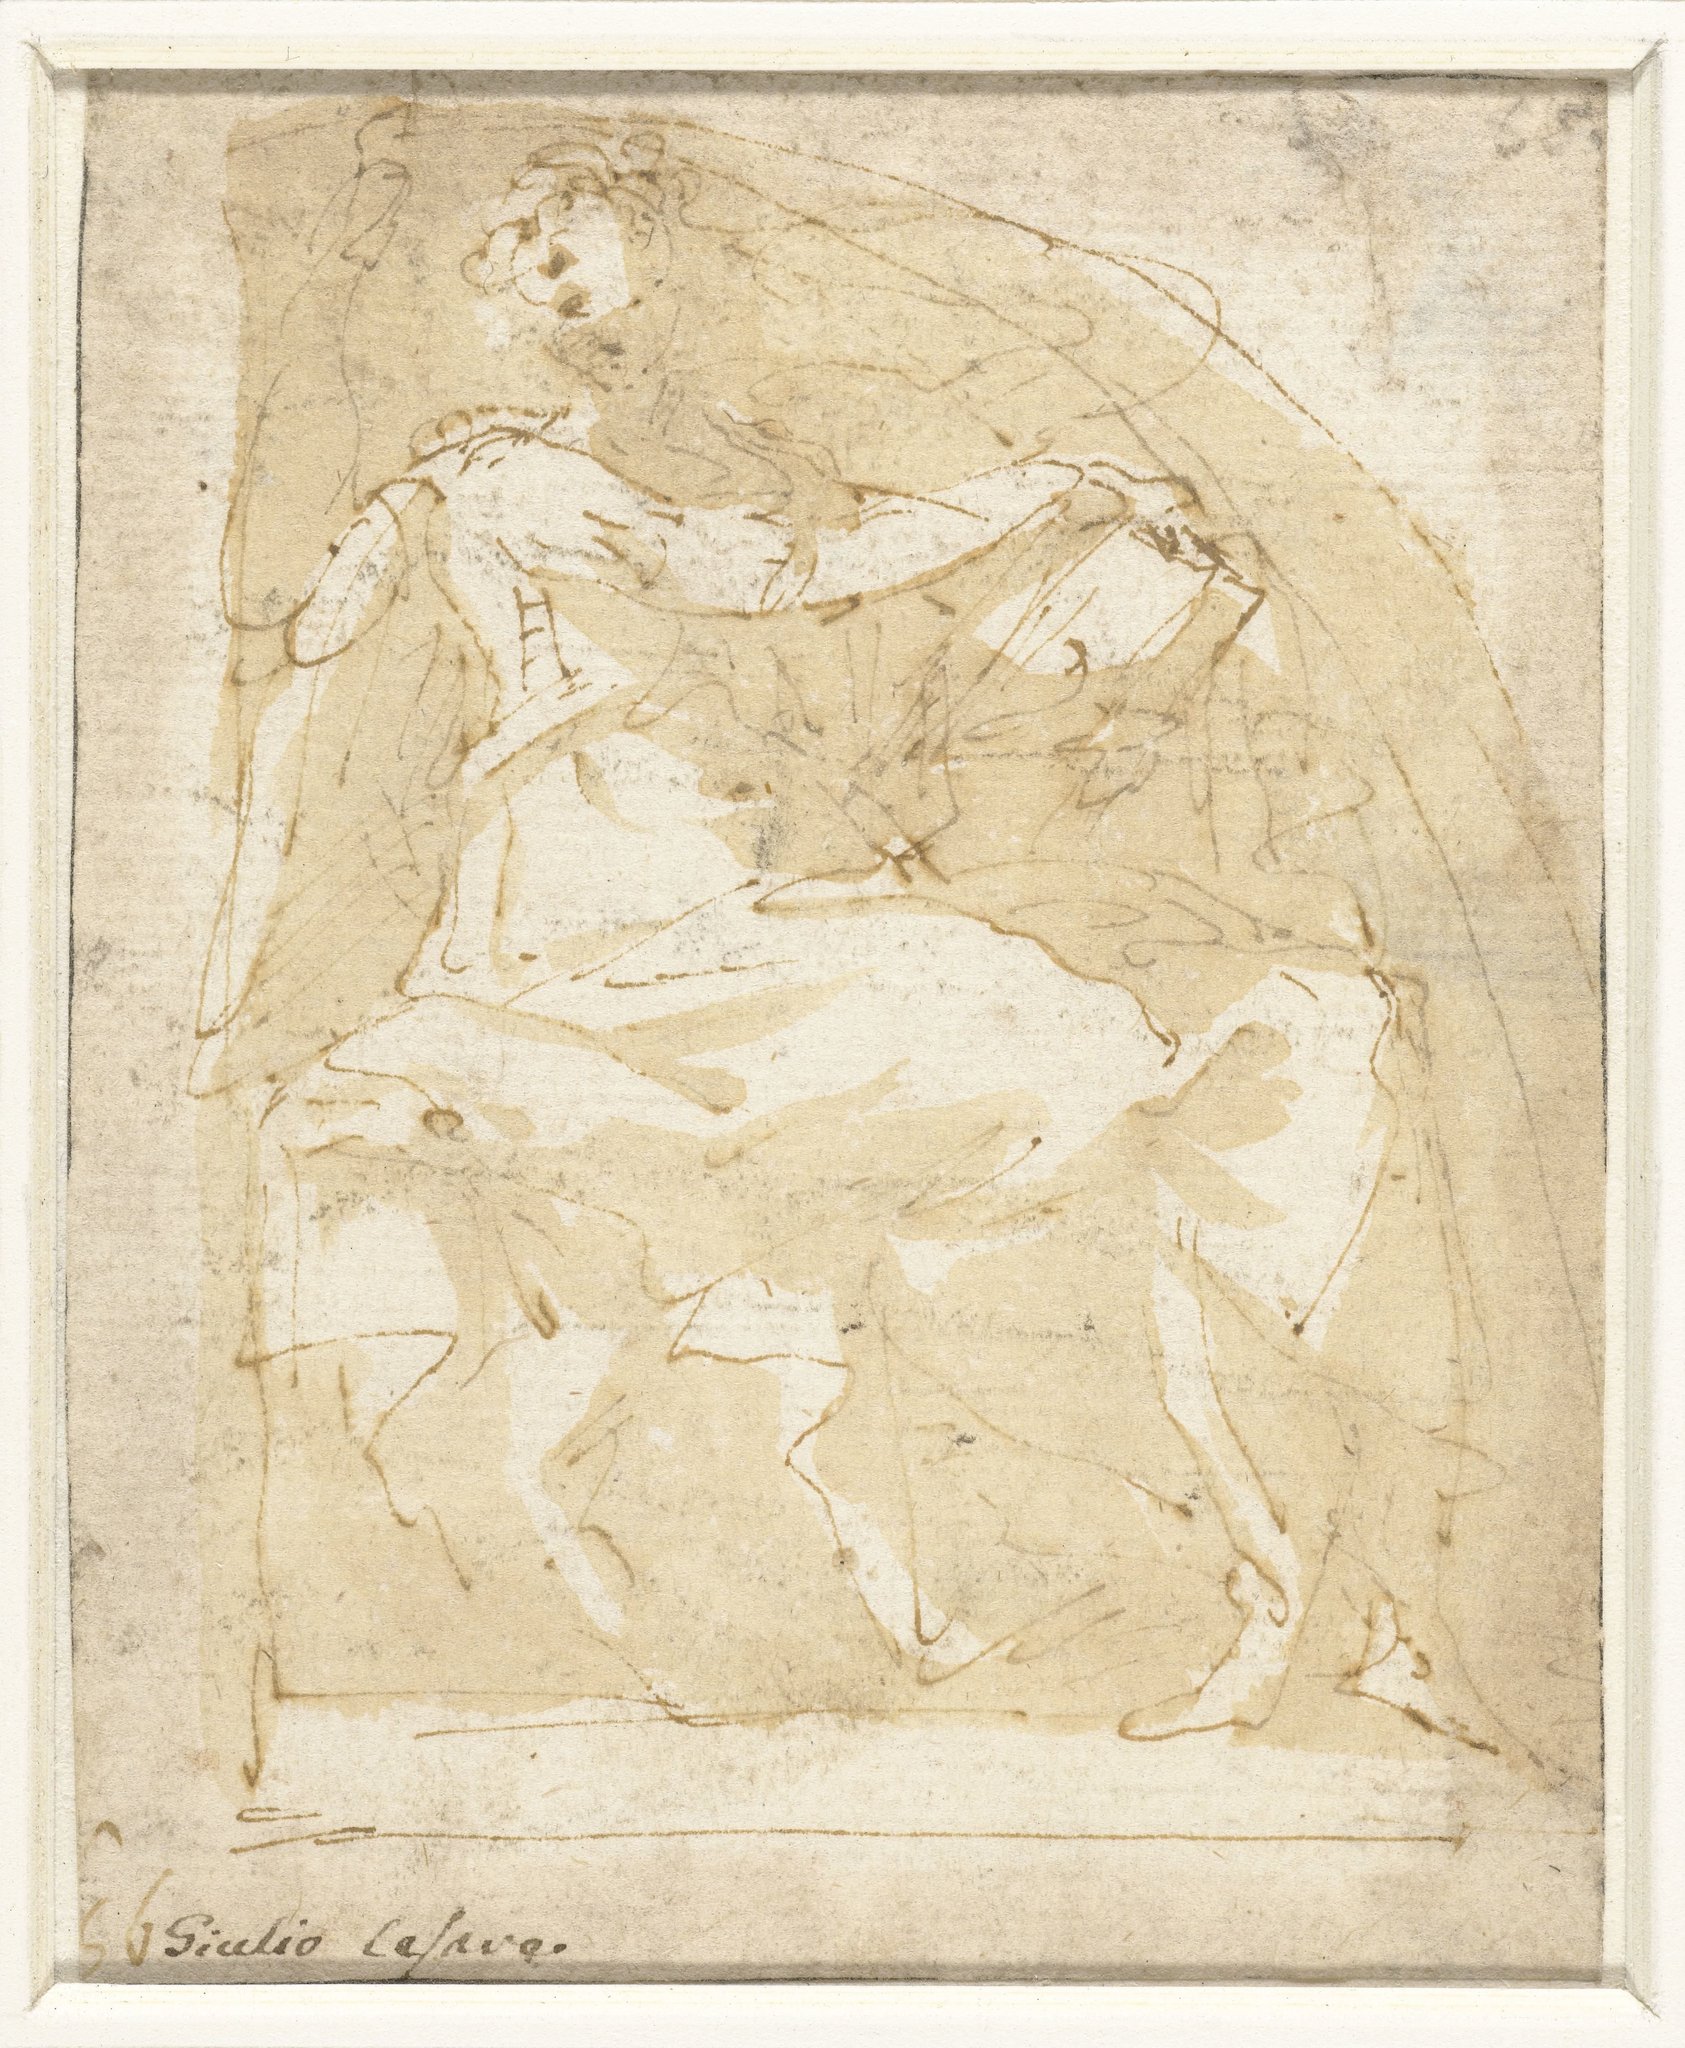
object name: drawing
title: Engel met een boek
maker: giulio cesare procaccini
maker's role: draughtsman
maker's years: 1570-1625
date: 1584-1625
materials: ink, paper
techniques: brush, pen